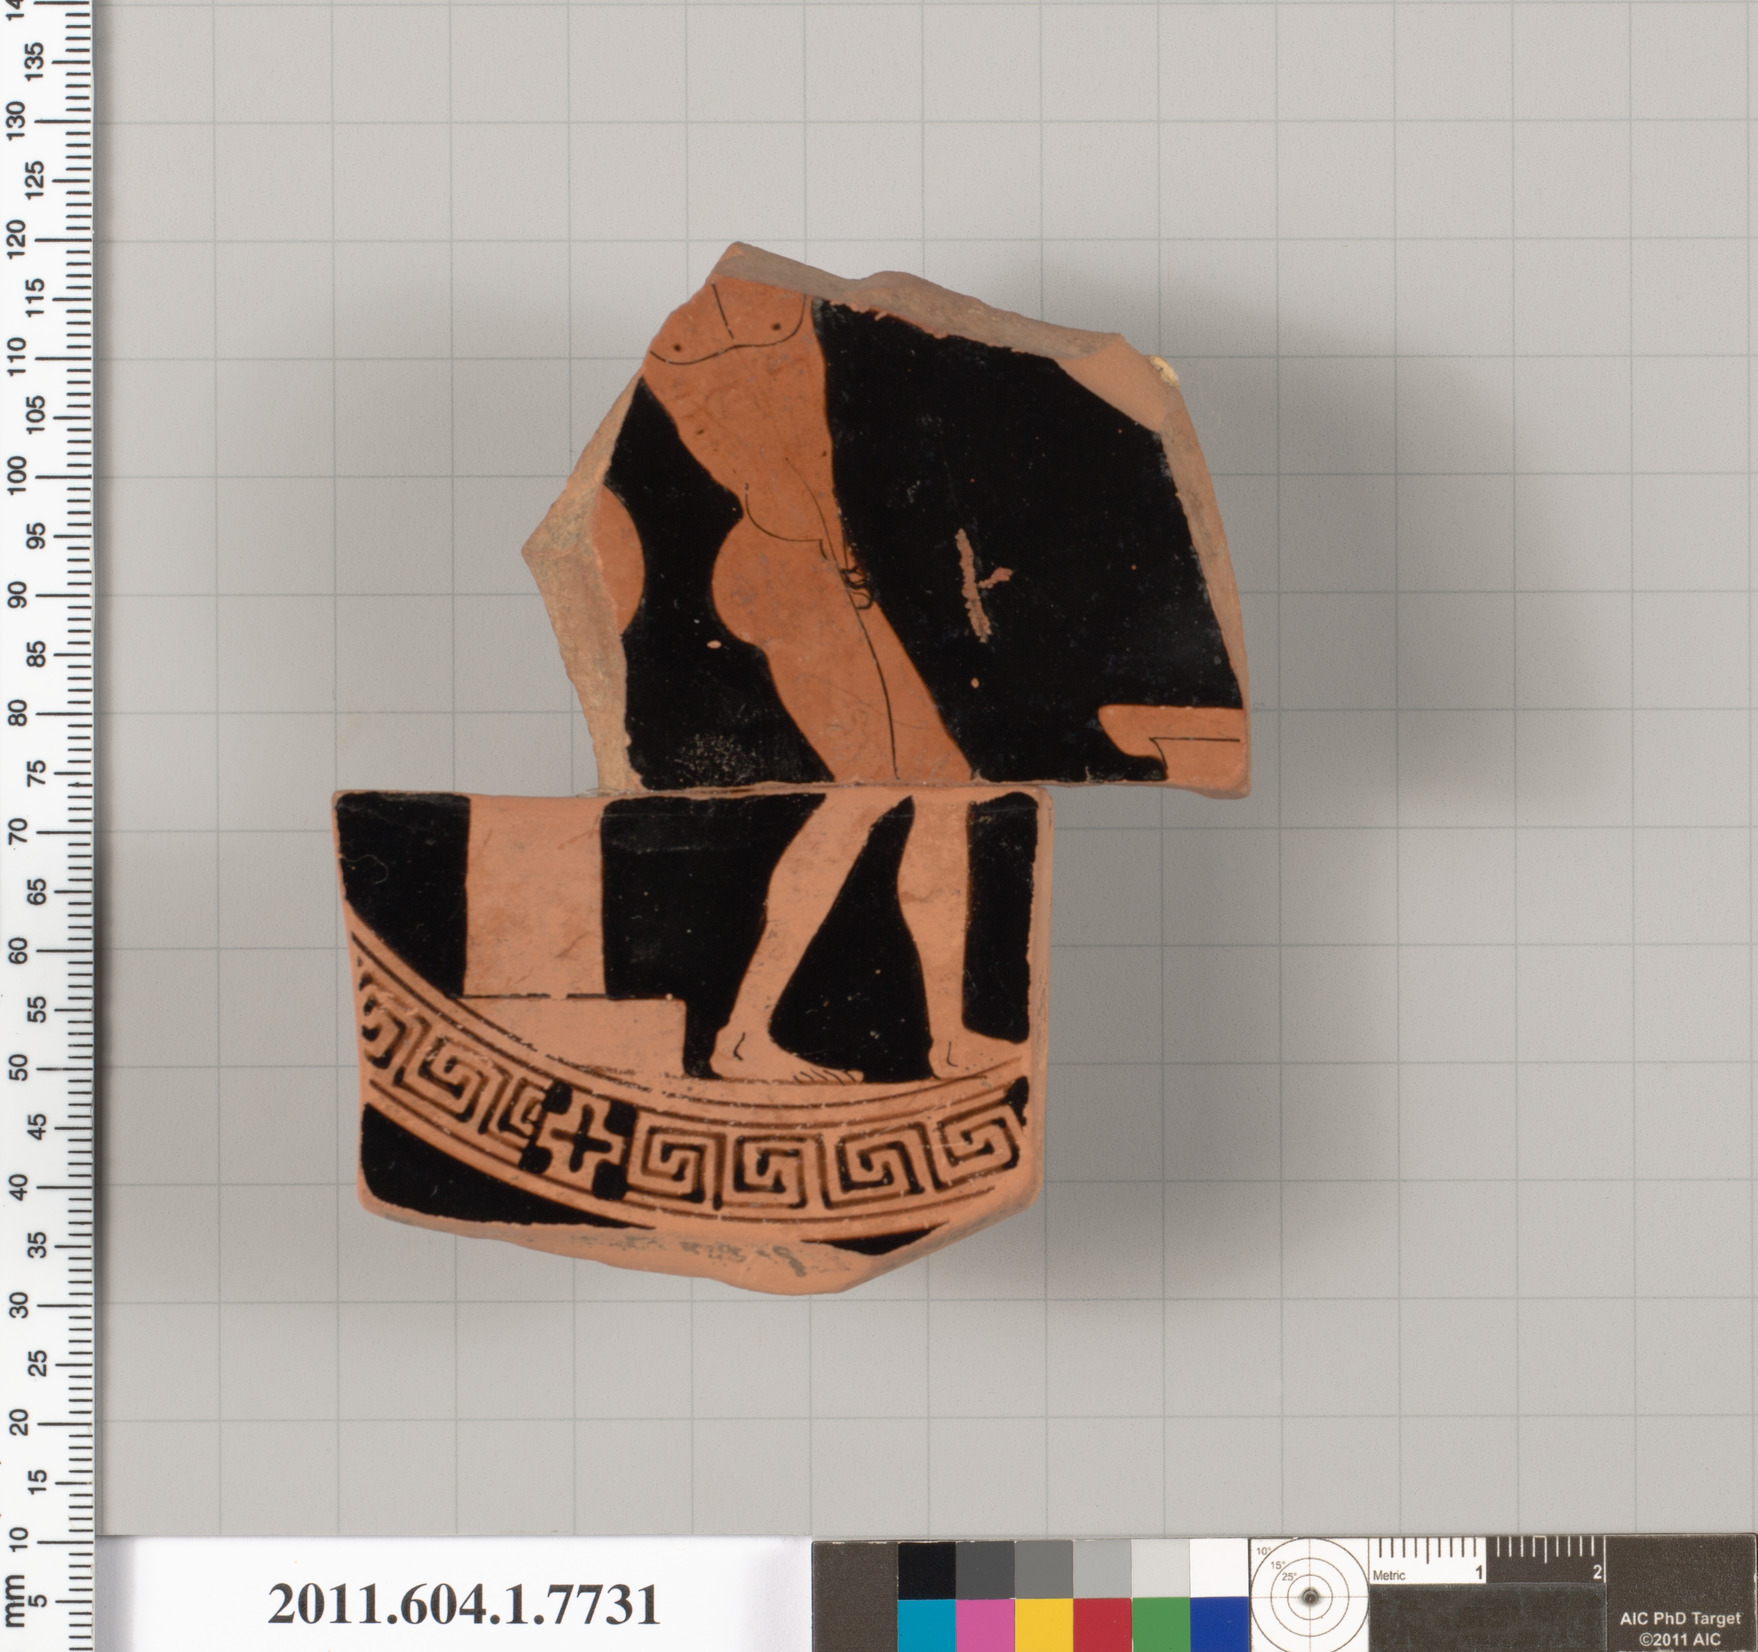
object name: kylix fragment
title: Terracotta fragment of a kylix (drinking cup)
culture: greek, attic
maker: orleans painter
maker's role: artist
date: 475-451 BCE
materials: terracotta